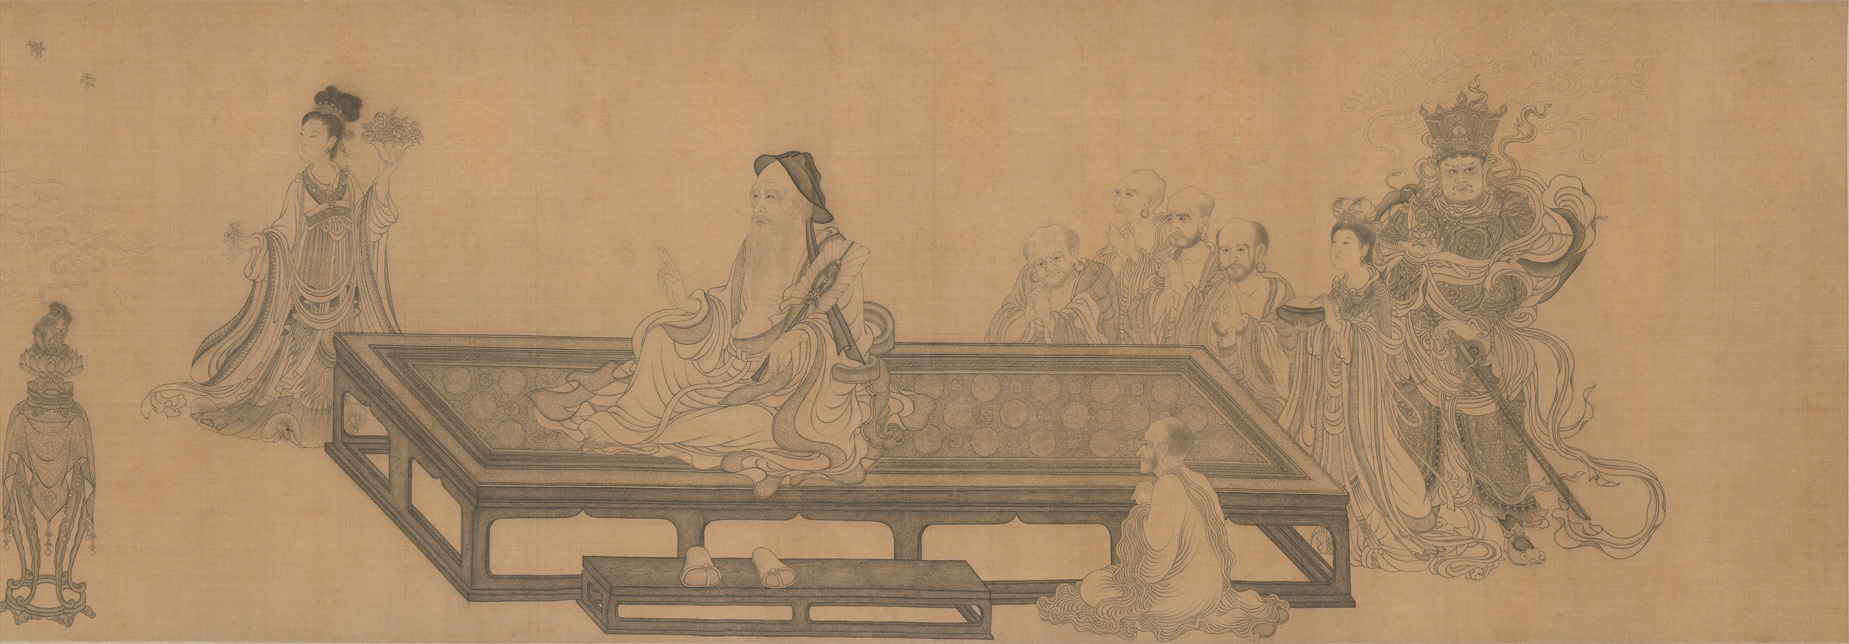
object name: handscroll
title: Vimalakirti and the Doctrine of Nonduality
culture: chinese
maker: wang zhenpeng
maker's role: artist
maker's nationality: chinese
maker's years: 1265-1340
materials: ink, silk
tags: men,women,buddhism,bodhisattvas,manjushri